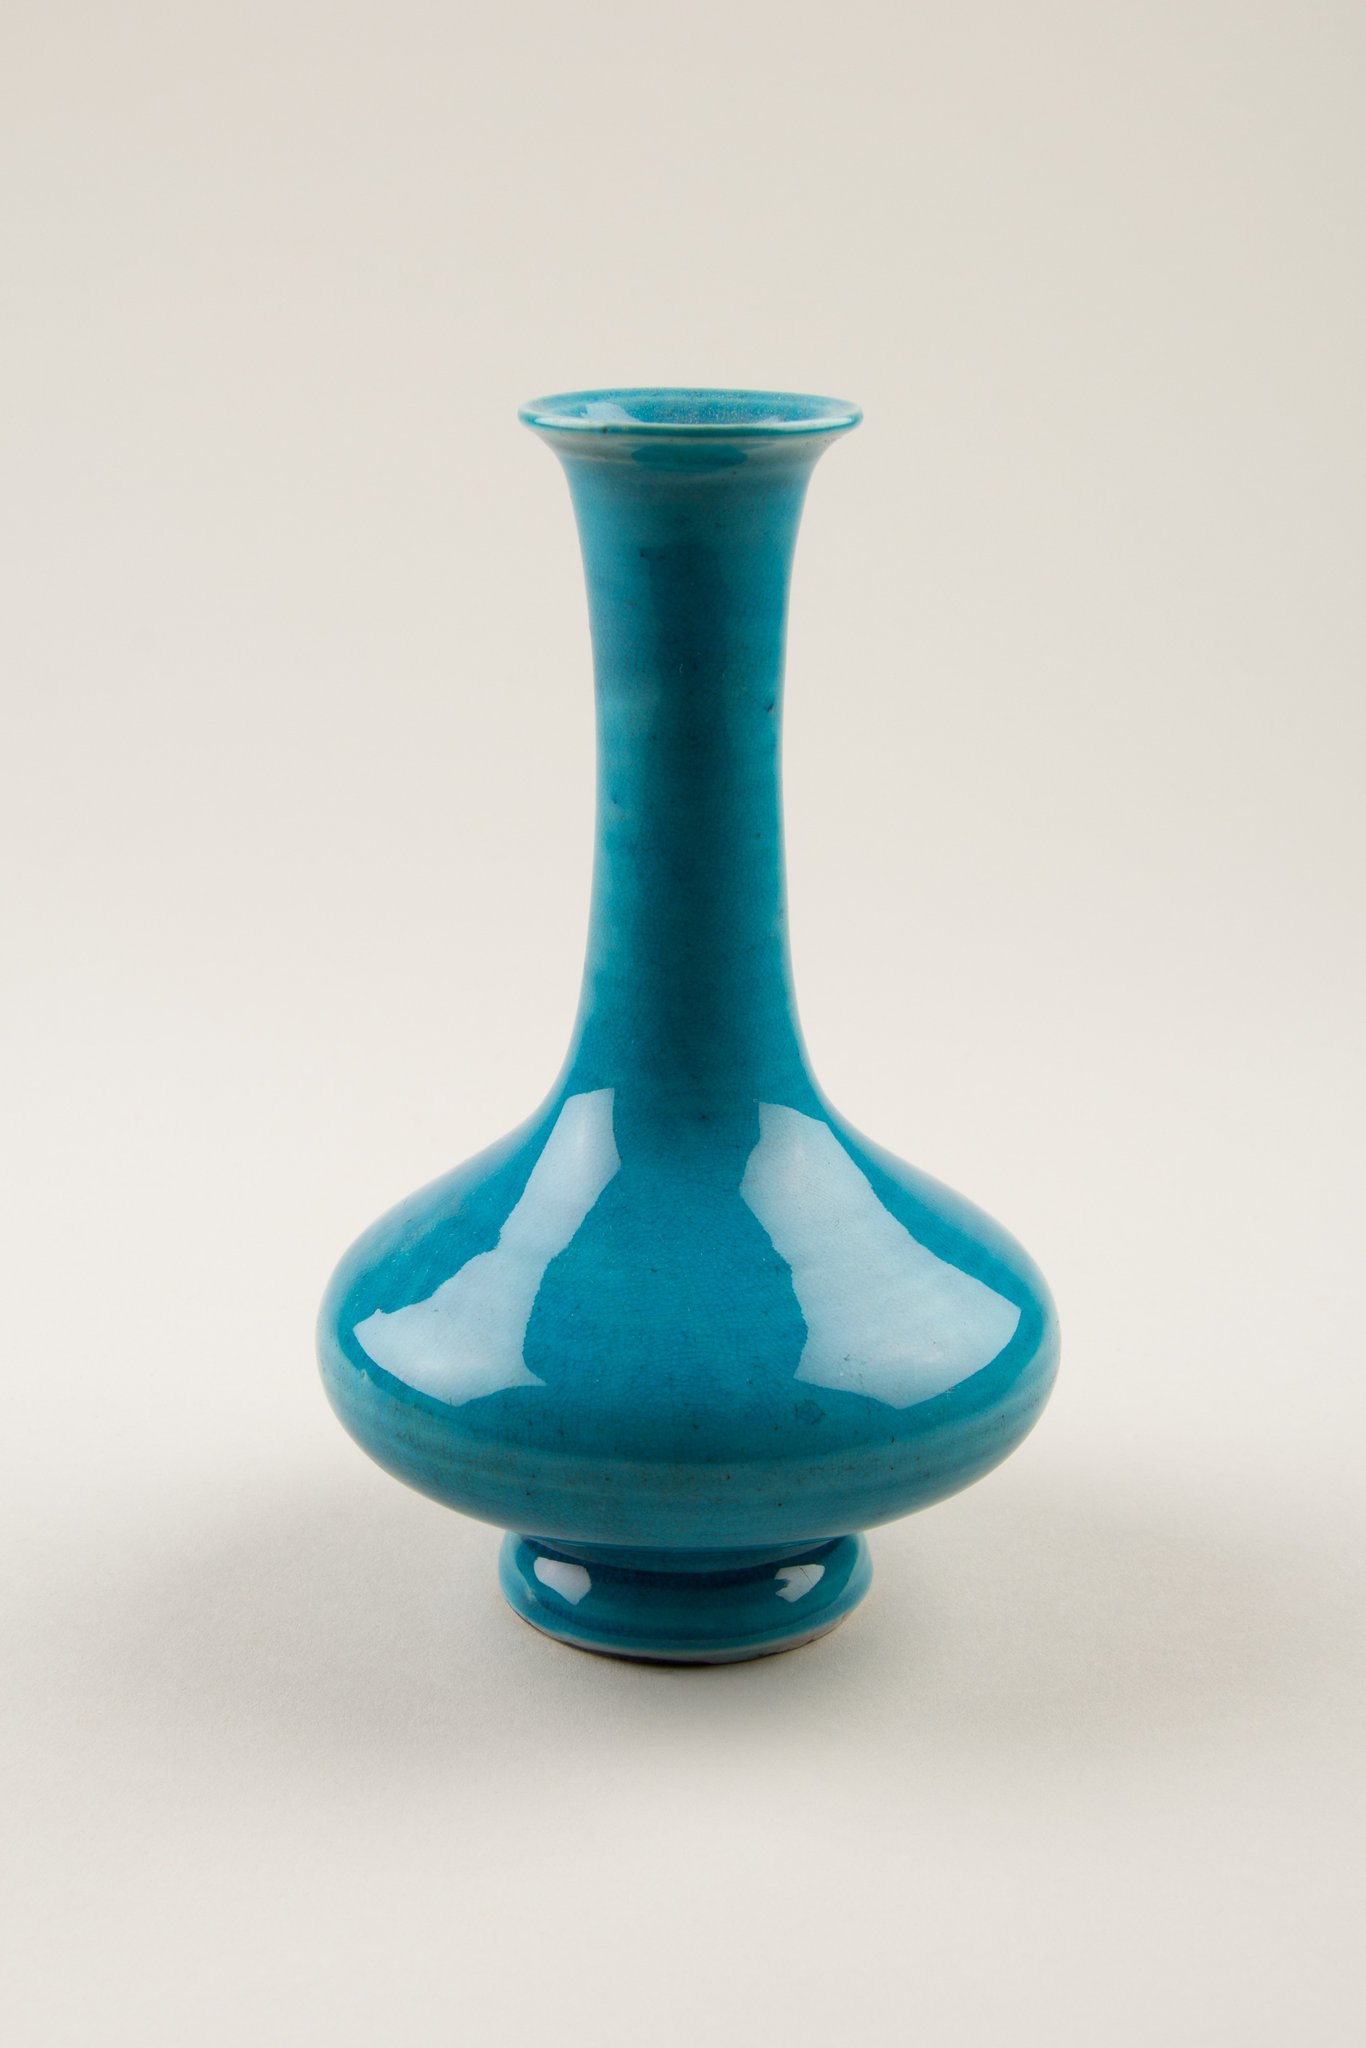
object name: bottle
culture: chinese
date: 1723-1735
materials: porcelain